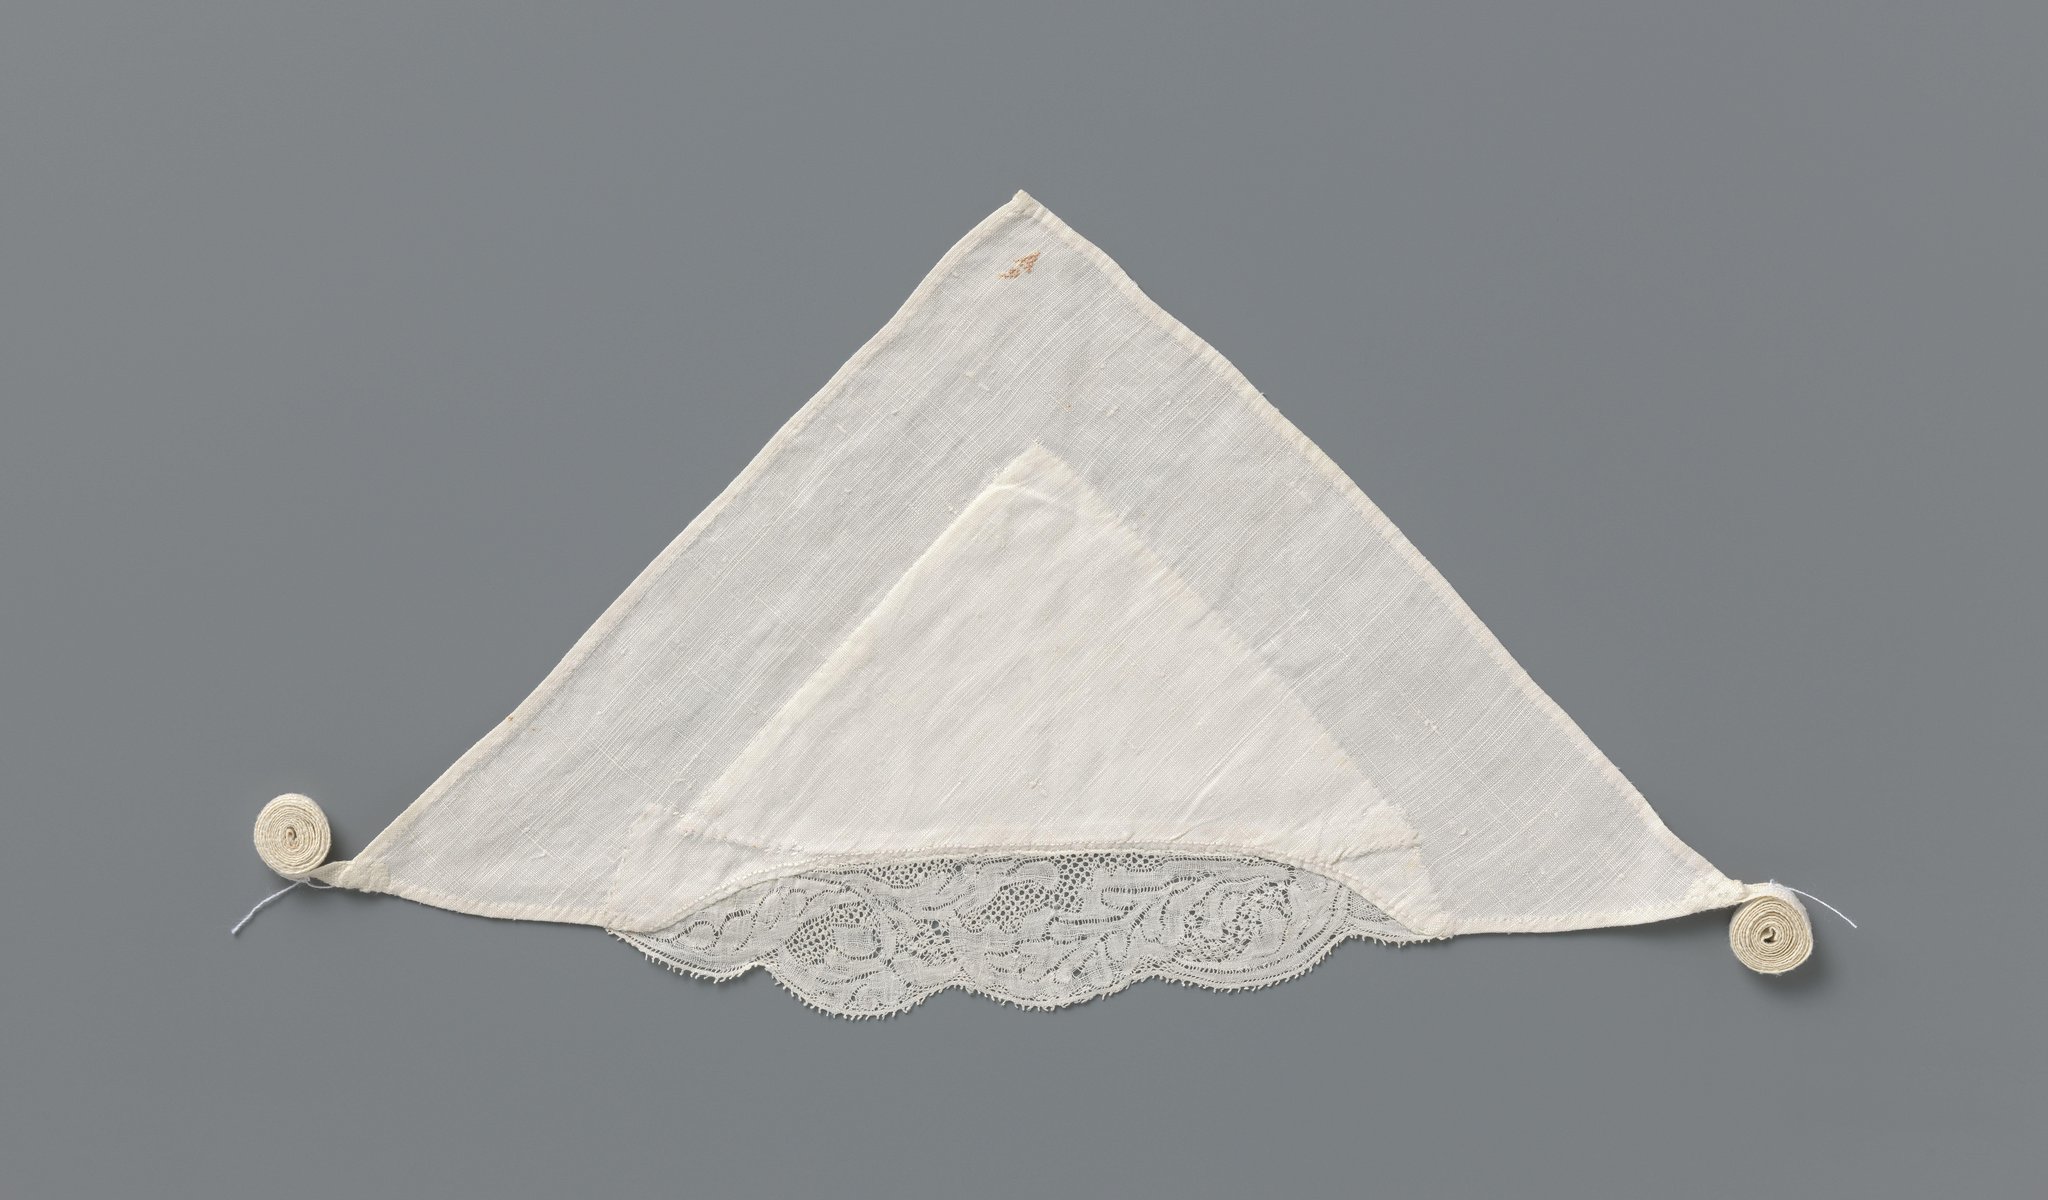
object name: childrenswear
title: Fontaneldoek van linnen met een strook kloskant met schulpenrand met dubbele rank en een hangbloem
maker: Anonymous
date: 1700-1799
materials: linen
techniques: lace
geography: europe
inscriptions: inscription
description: Fontaneldoek van linnen met een strook naturelkleurige kloskant, Binche-kant. Patroon met een schulpenrand met dubbele rank en een hangbloem tegen een vijfgaatjesgrond.